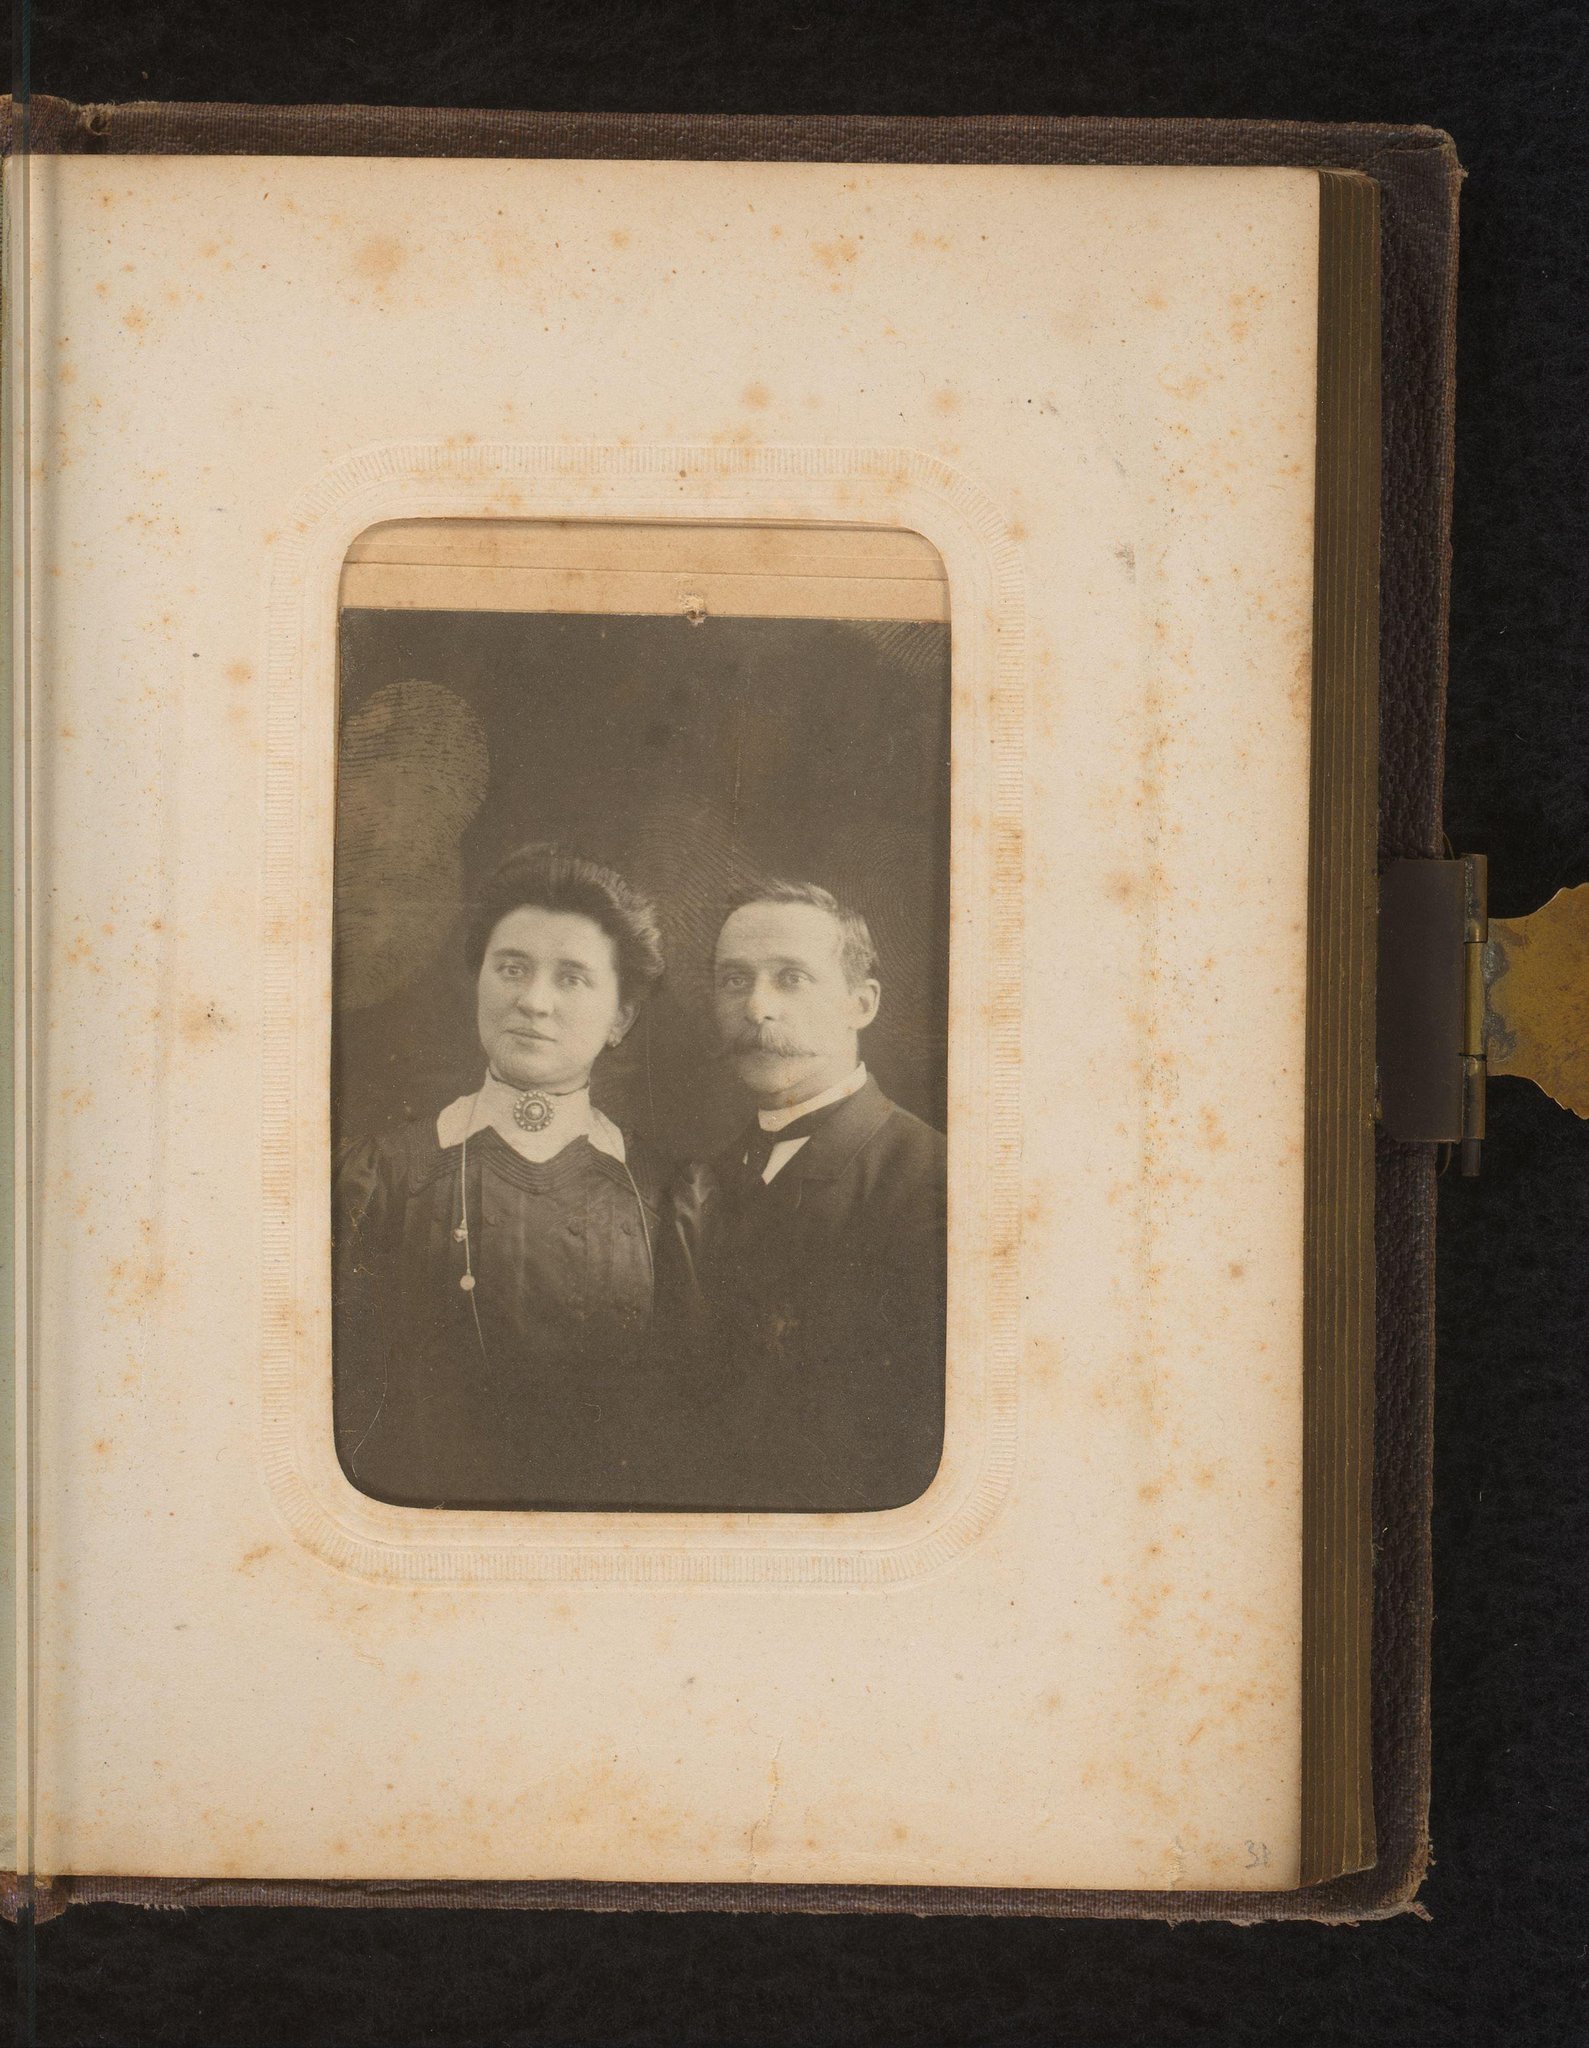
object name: carte de visite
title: Portret van een vrouw en man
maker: Anonymous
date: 1880-1920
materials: cardboard, photographic support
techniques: daylight paper print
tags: adult woman, adult man, historical persons